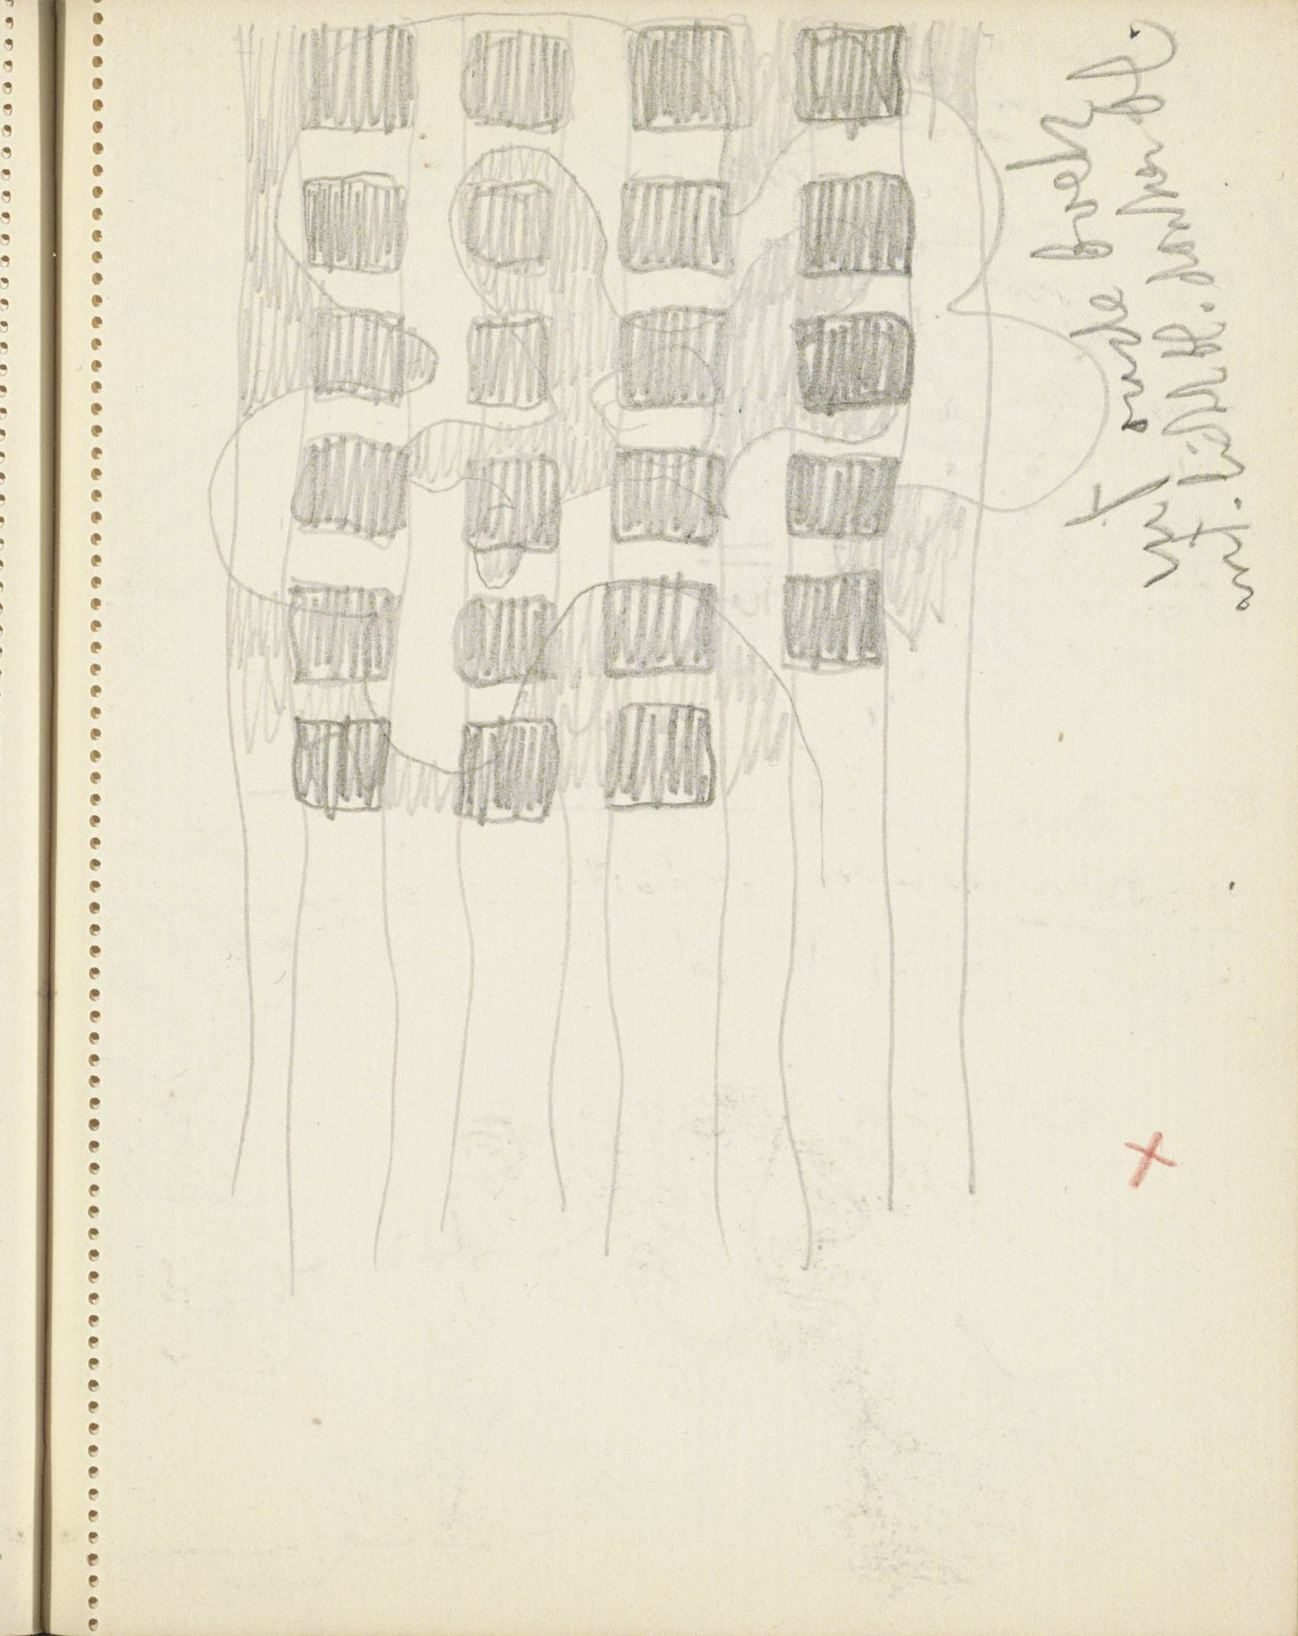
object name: sketchbook leaf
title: Decoratief patroon met vierkanten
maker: reijer stolk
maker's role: draughtsman, print maker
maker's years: 1896-1945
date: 1916-1945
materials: paper, pencil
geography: africa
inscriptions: annotation: ‘uit oude boek/ [...]t lichtbl. donker bl.’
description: Mogelijk een weefpatroon. Blad 38 recto uit een schetsboek met 60 bladen.